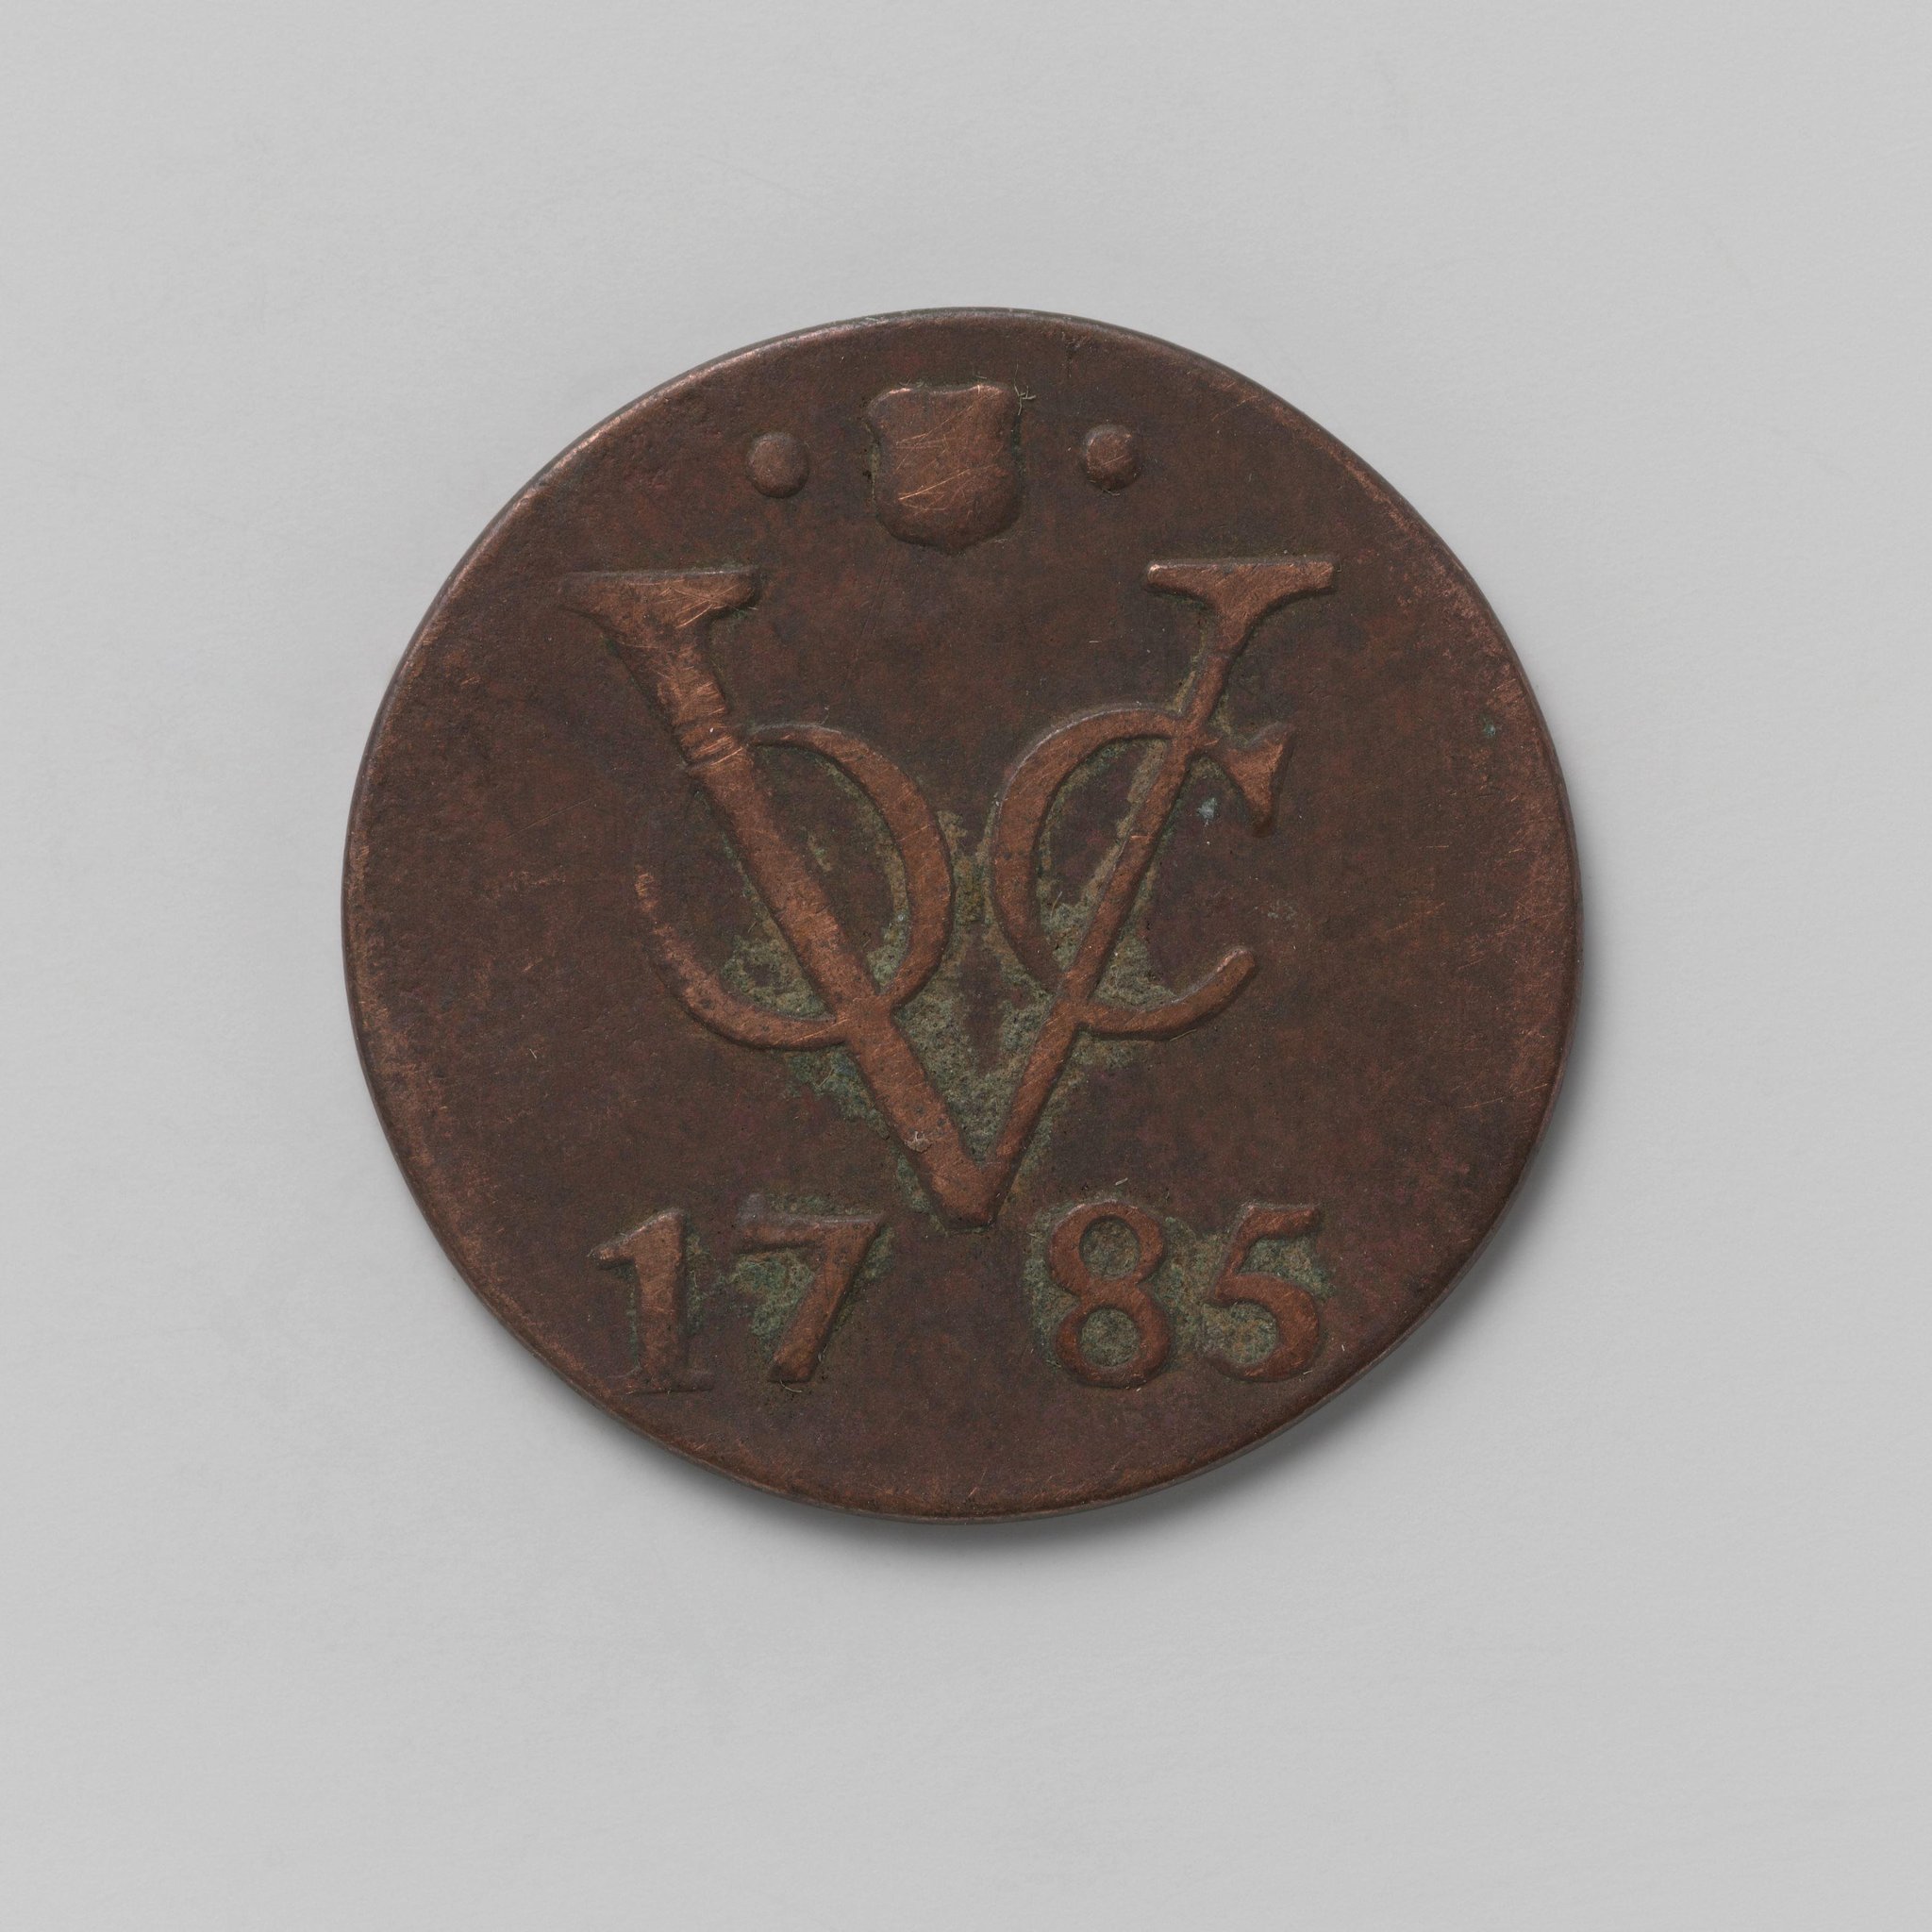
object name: coin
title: Duit van de VOC uit de stad Utrecht,1785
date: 1785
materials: copper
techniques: striking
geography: utrecht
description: Koperen munt. Voorzijde: op balk, waaronder guirlande, geplaatst, door twee leeuwen gehouden gekroond wapenschild van de stad Utrecht. Keerzijde: monogram van de VOC, waarboven muntteken en waaronder jaartal. Gladde rand.